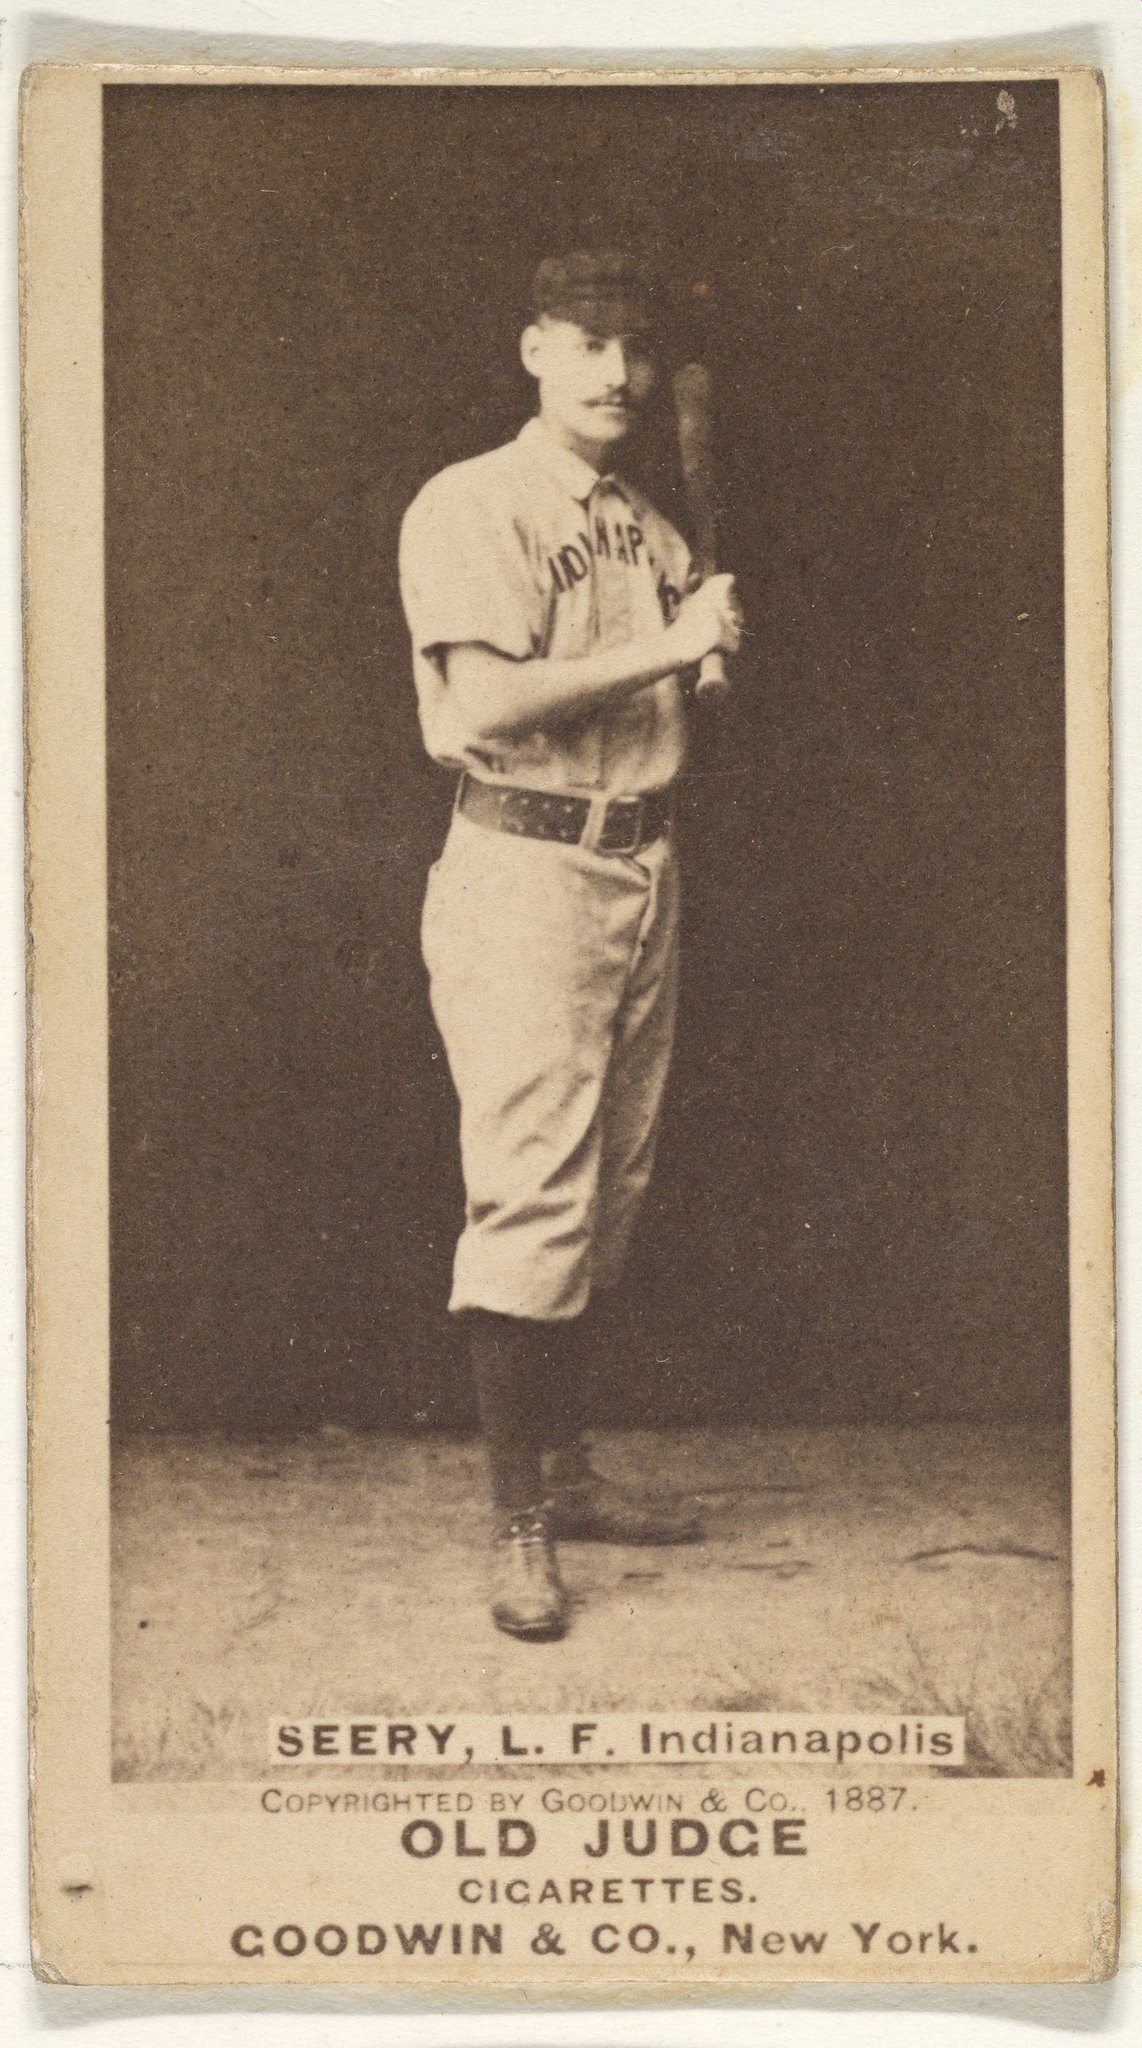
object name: baseball card, photograph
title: Seery, Left Field, Indianapolis, from the Old Judge series (N172) for Old Judge Cigarettes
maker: goodwin & company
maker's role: publisher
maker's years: 1850-1950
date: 1887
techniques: albumen silver print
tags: men,portraits,baseball,athletes